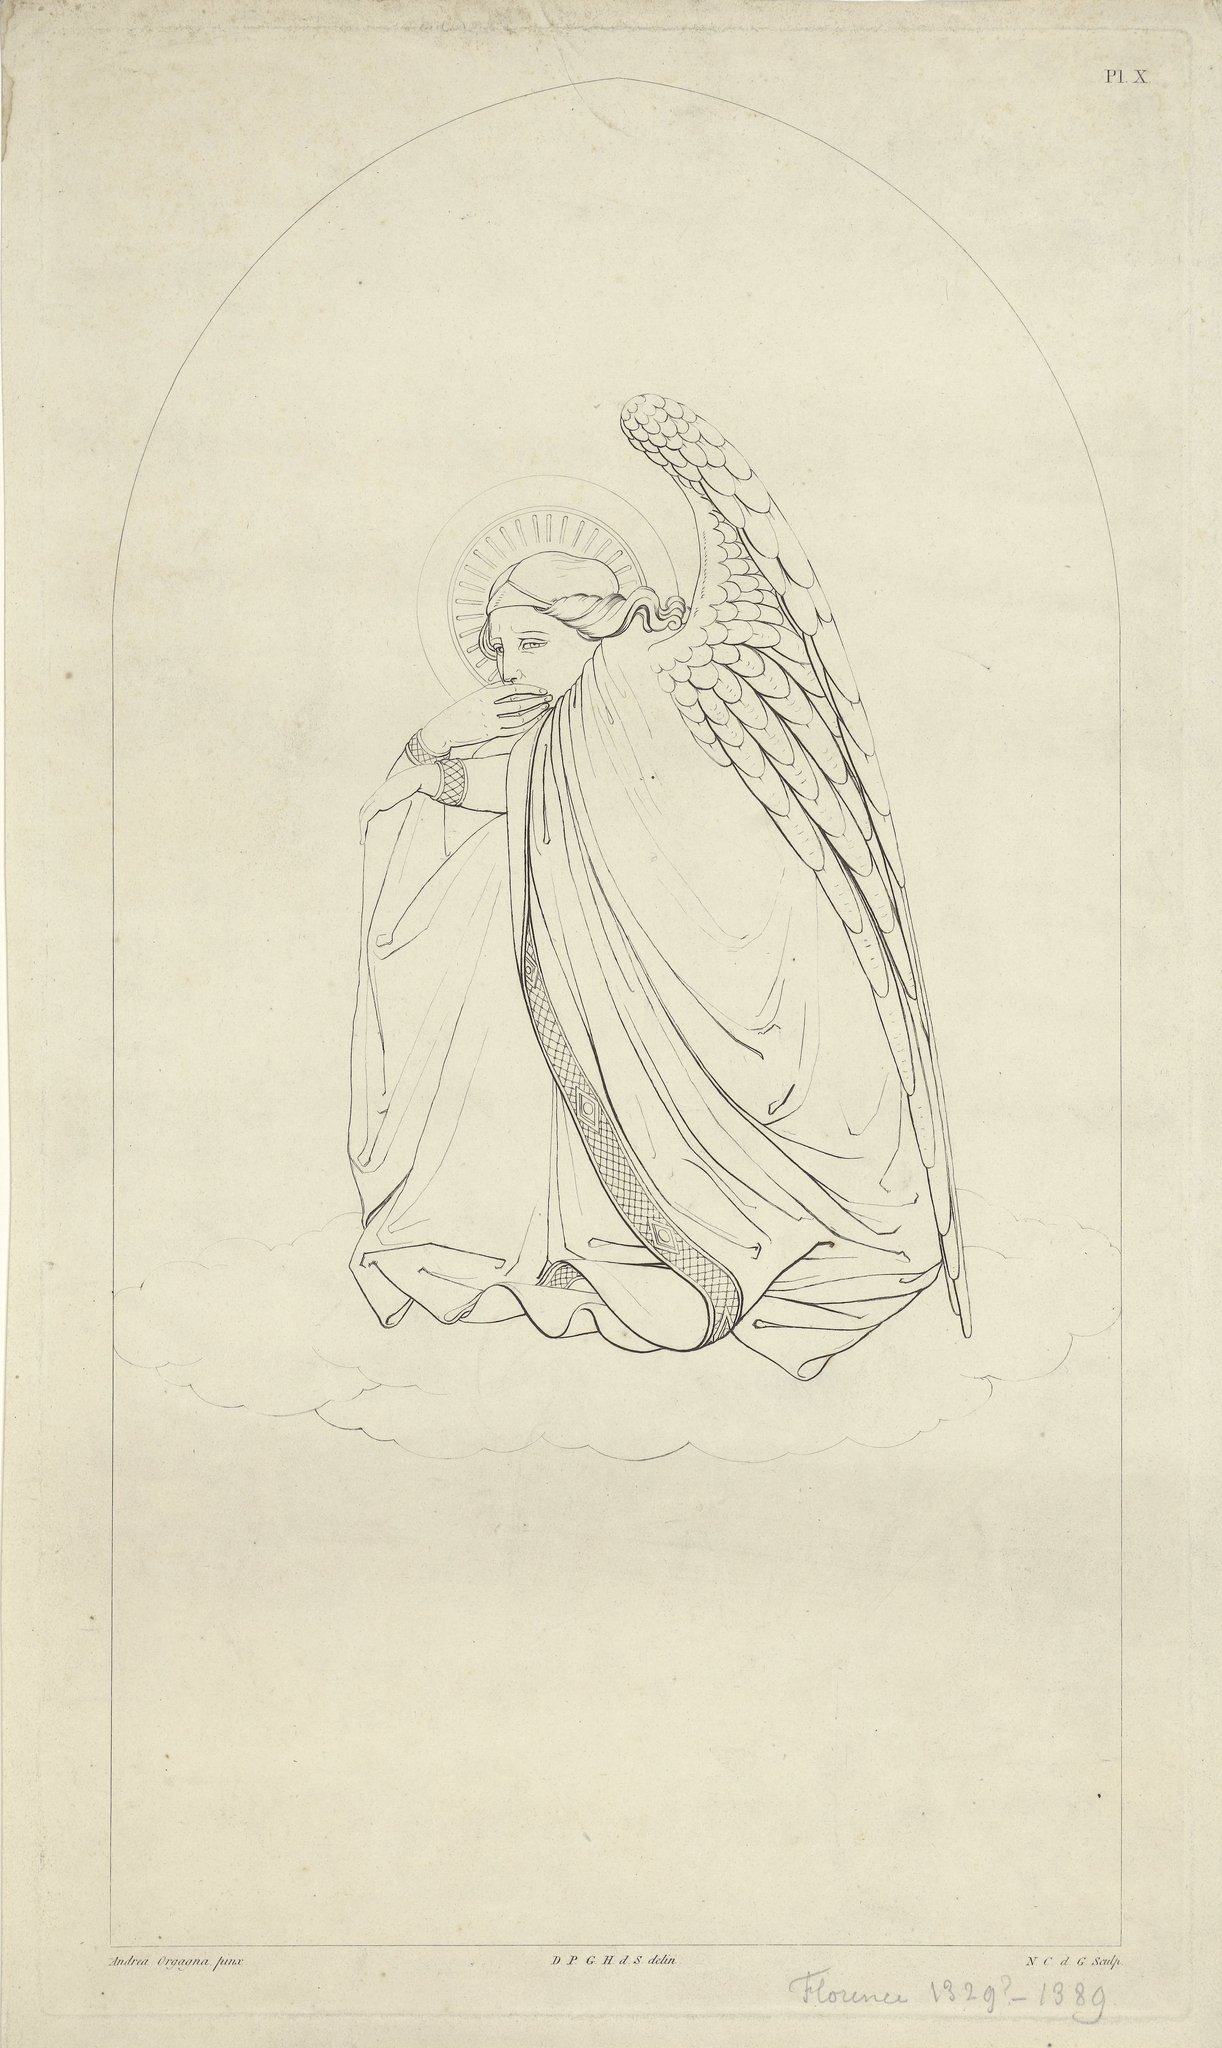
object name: print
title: Gehurkte engel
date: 1802-1873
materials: paper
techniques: etching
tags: angels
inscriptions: collector's mark: Lugt 2228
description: Een gehurkte engel met de hand voor de mond. Genummerd X.